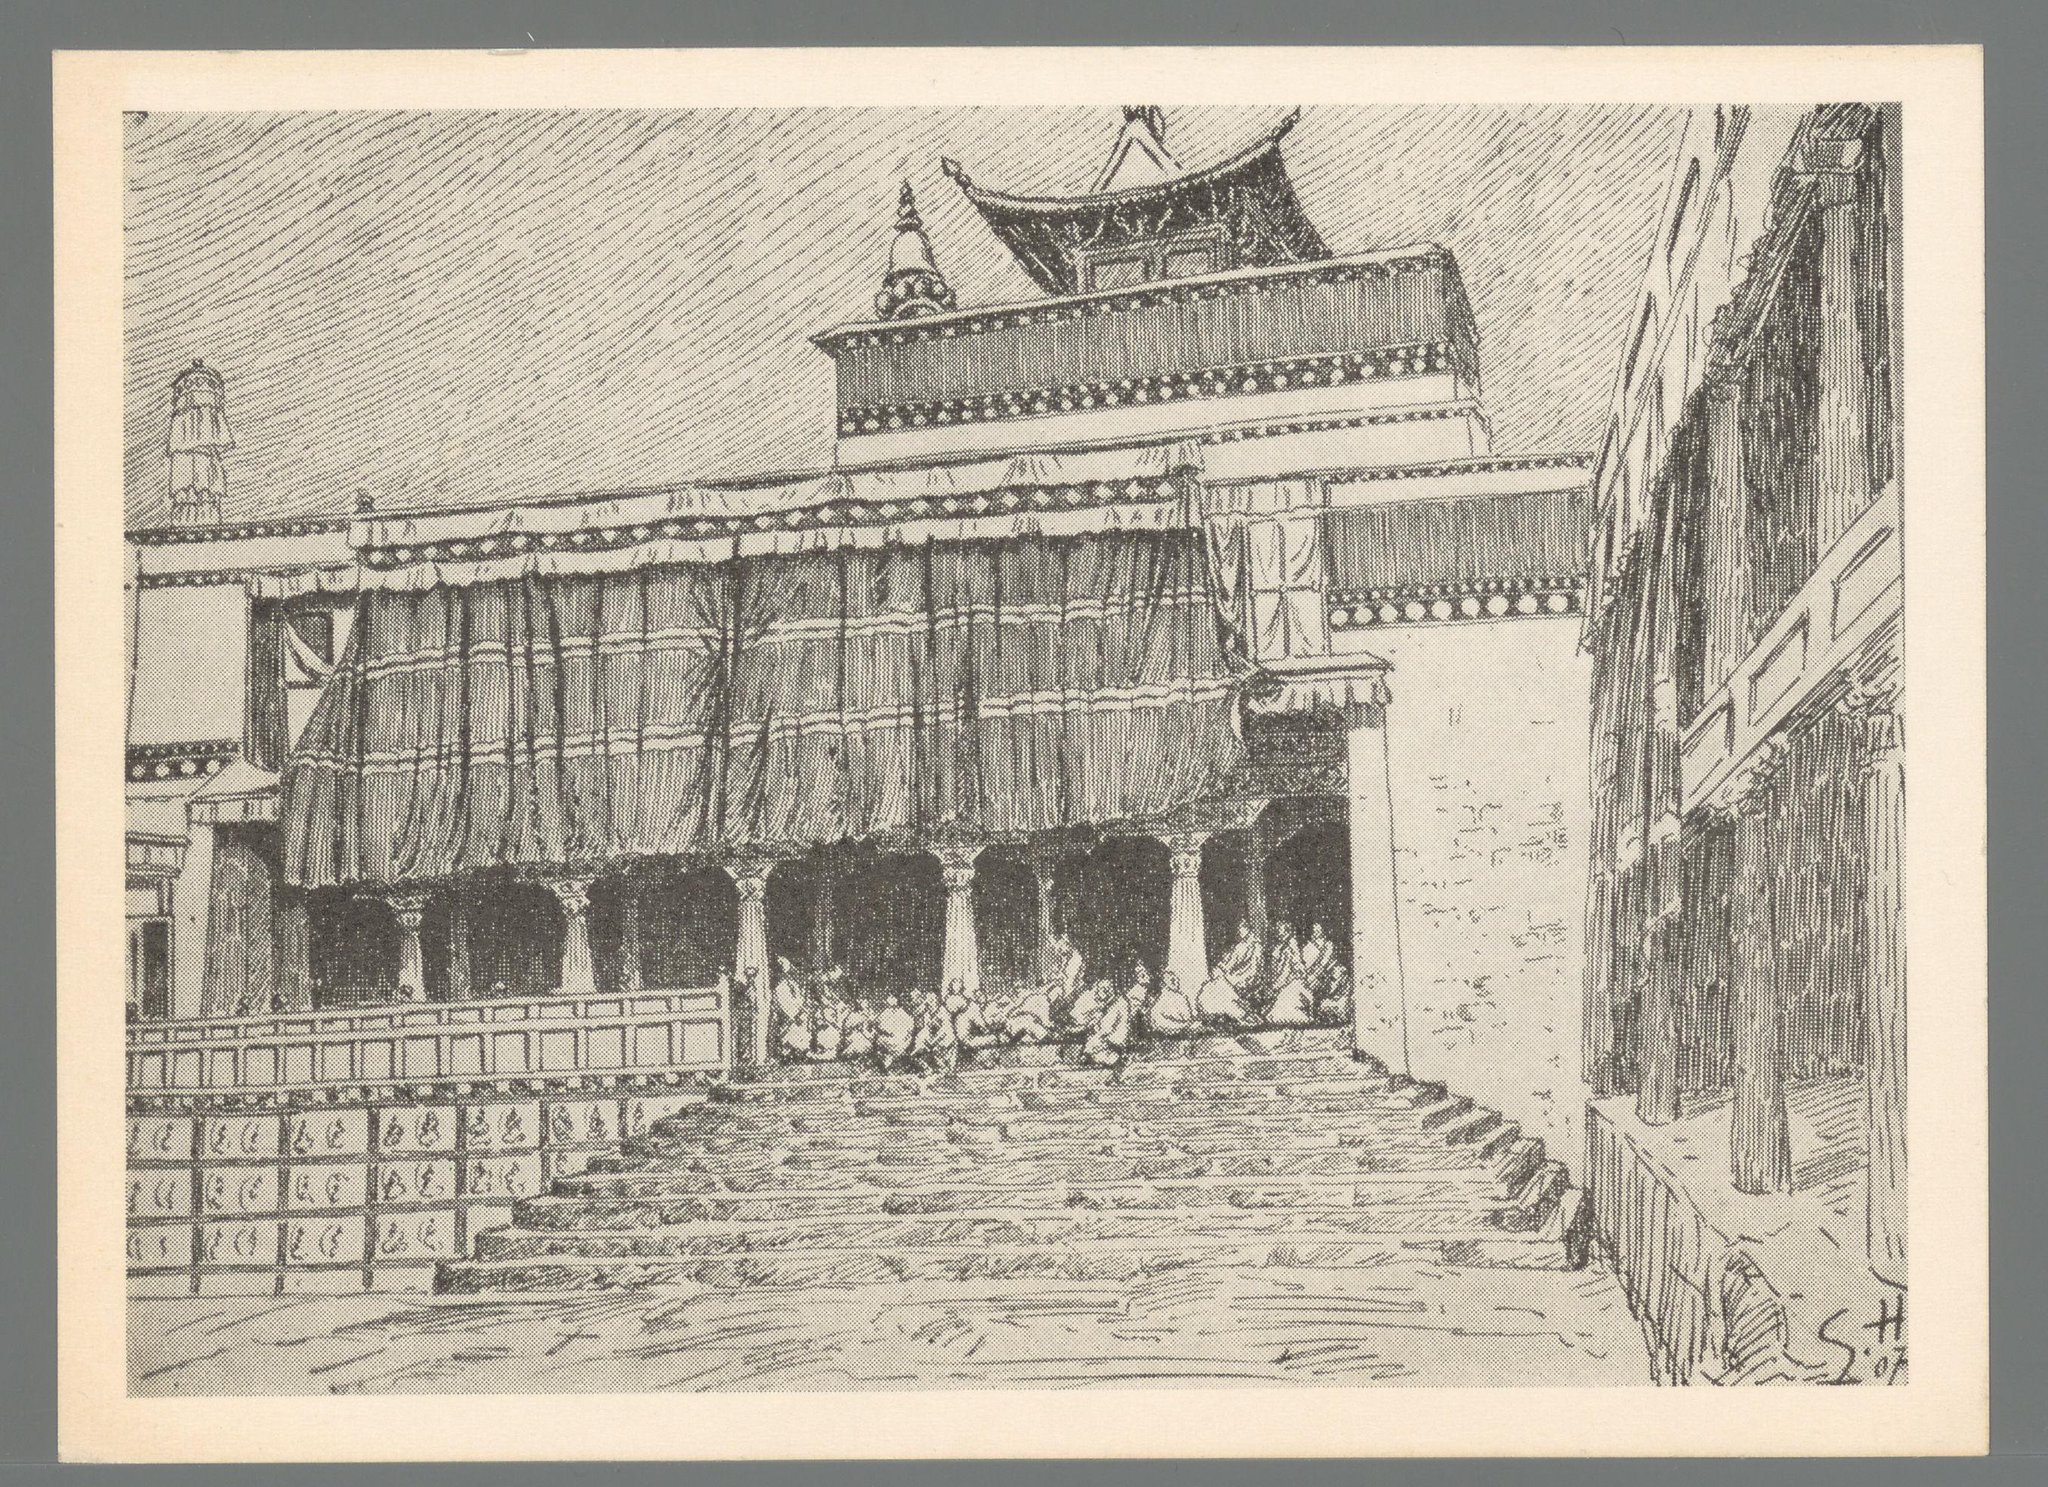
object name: photomechanical print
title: Tempelgården i Shigatse, Tibet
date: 1952-1979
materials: cardboard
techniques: autotype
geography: stockholm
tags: temple, shrine ~ hinduism, buddhism, jainism, front steps